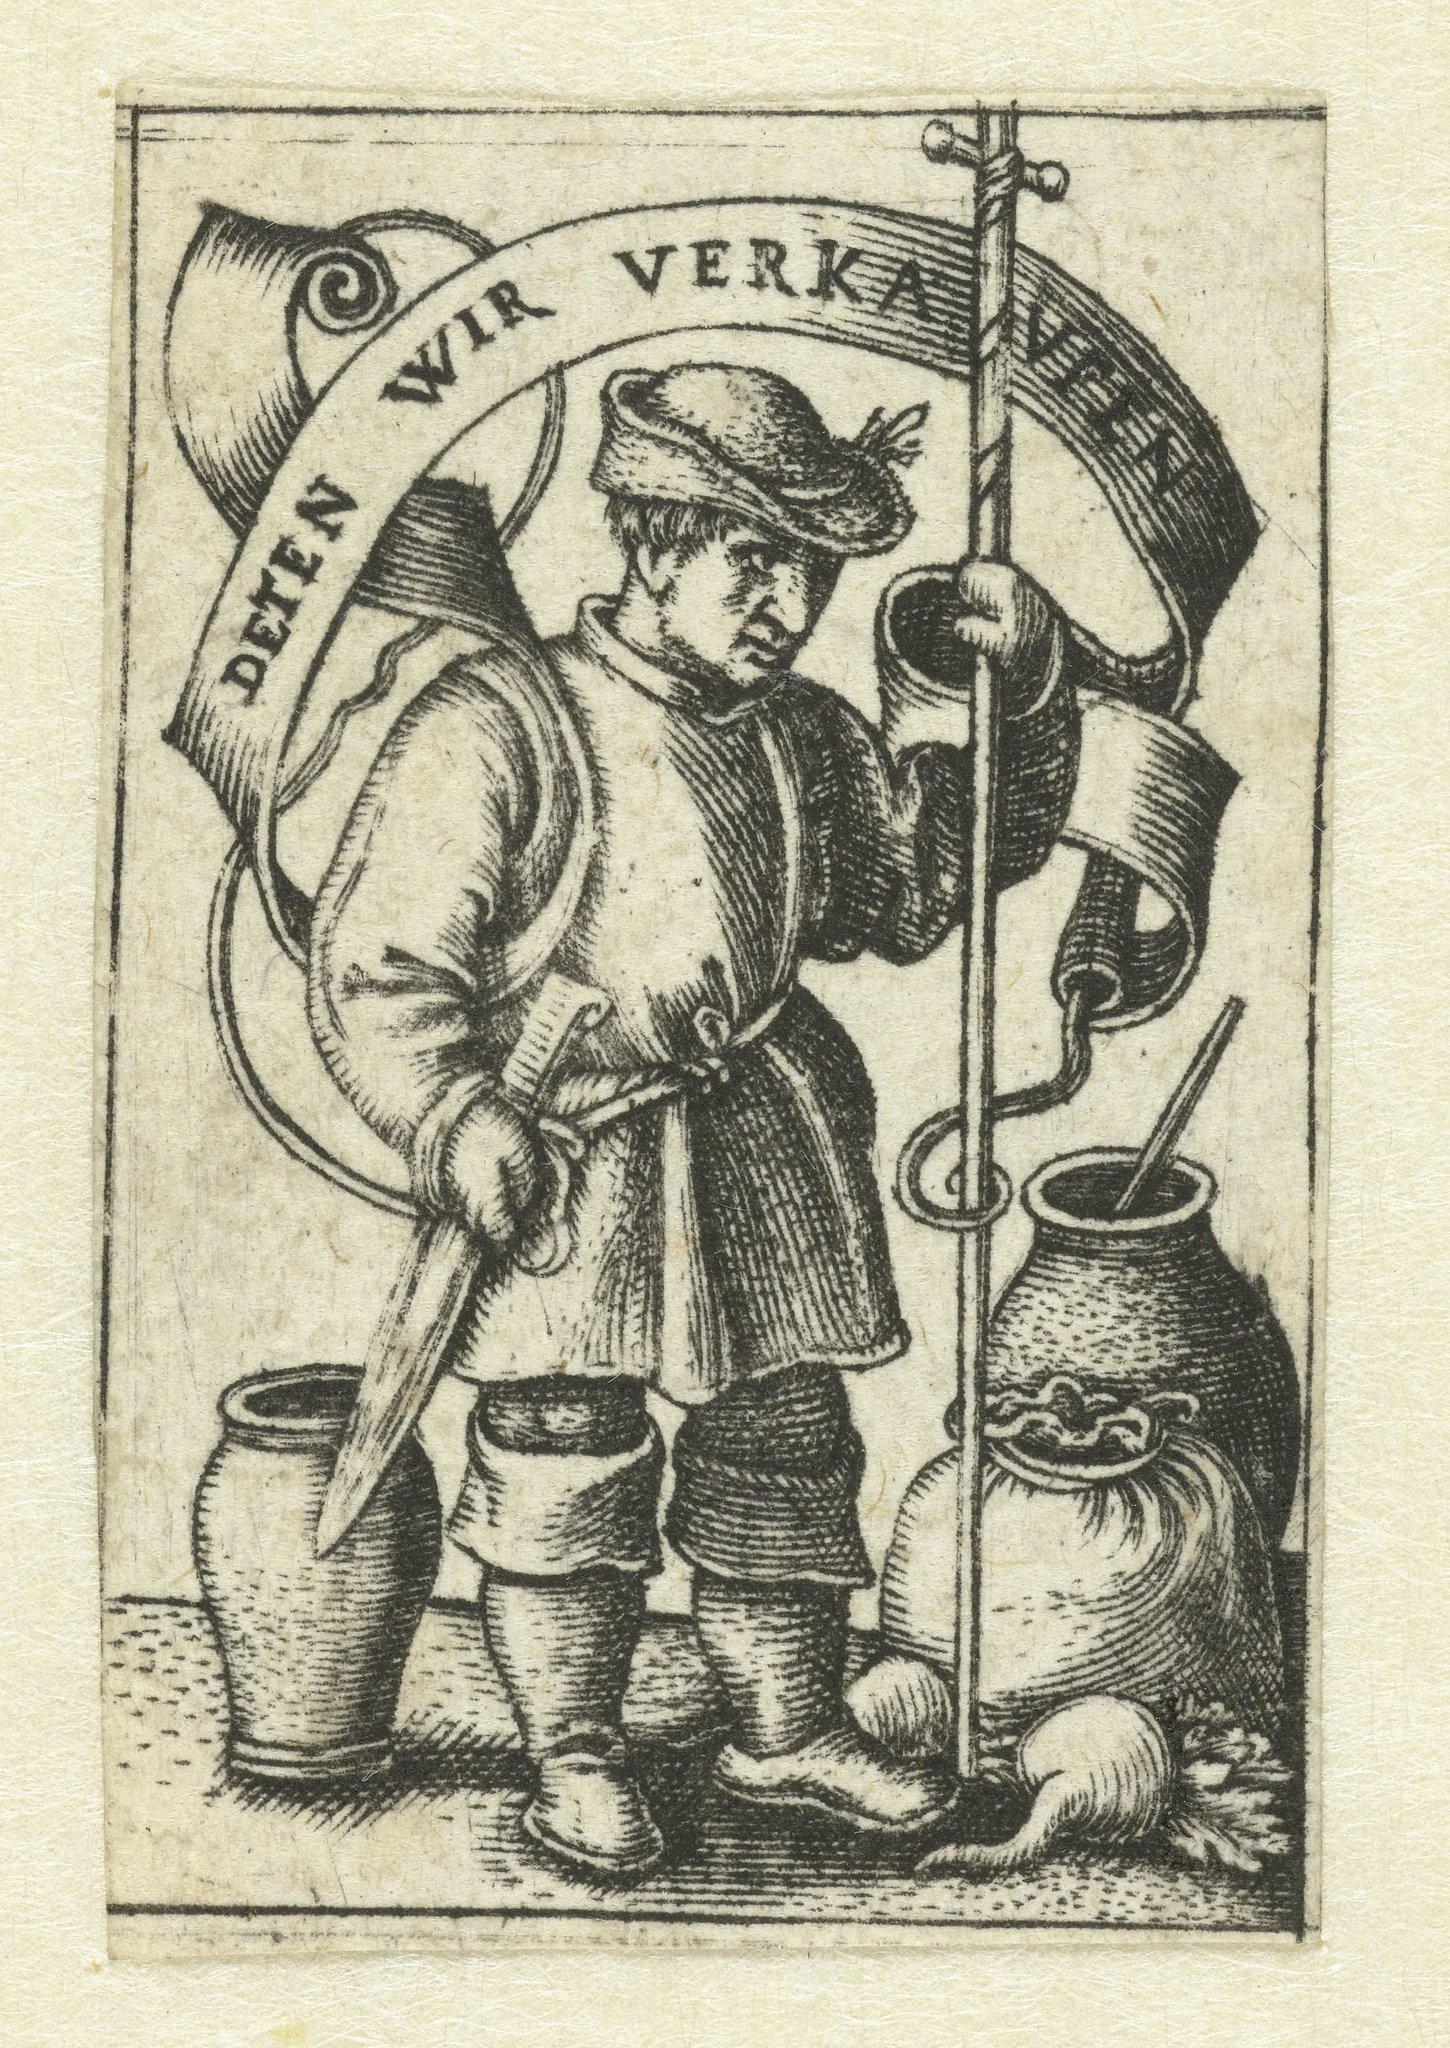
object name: print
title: Boer verkoopt zijn produkten op markt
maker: Anonymous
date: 1510-1599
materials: paper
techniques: engraving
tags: merchant, salesman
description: Dit prentje met een boer die zijn produkten verkoopt op de markt heeft een pendant met een boerin die haar waren heeft uitgestald. De figuren zijn naar elkaar toegewend weergegeven met de titels op tekstbanden welke volledig geïntegreerd zijn met de figuren en hun attributen. Beiden zijn vrij nauwkeurige kopieën naar prenten van Hans Sebald Beham